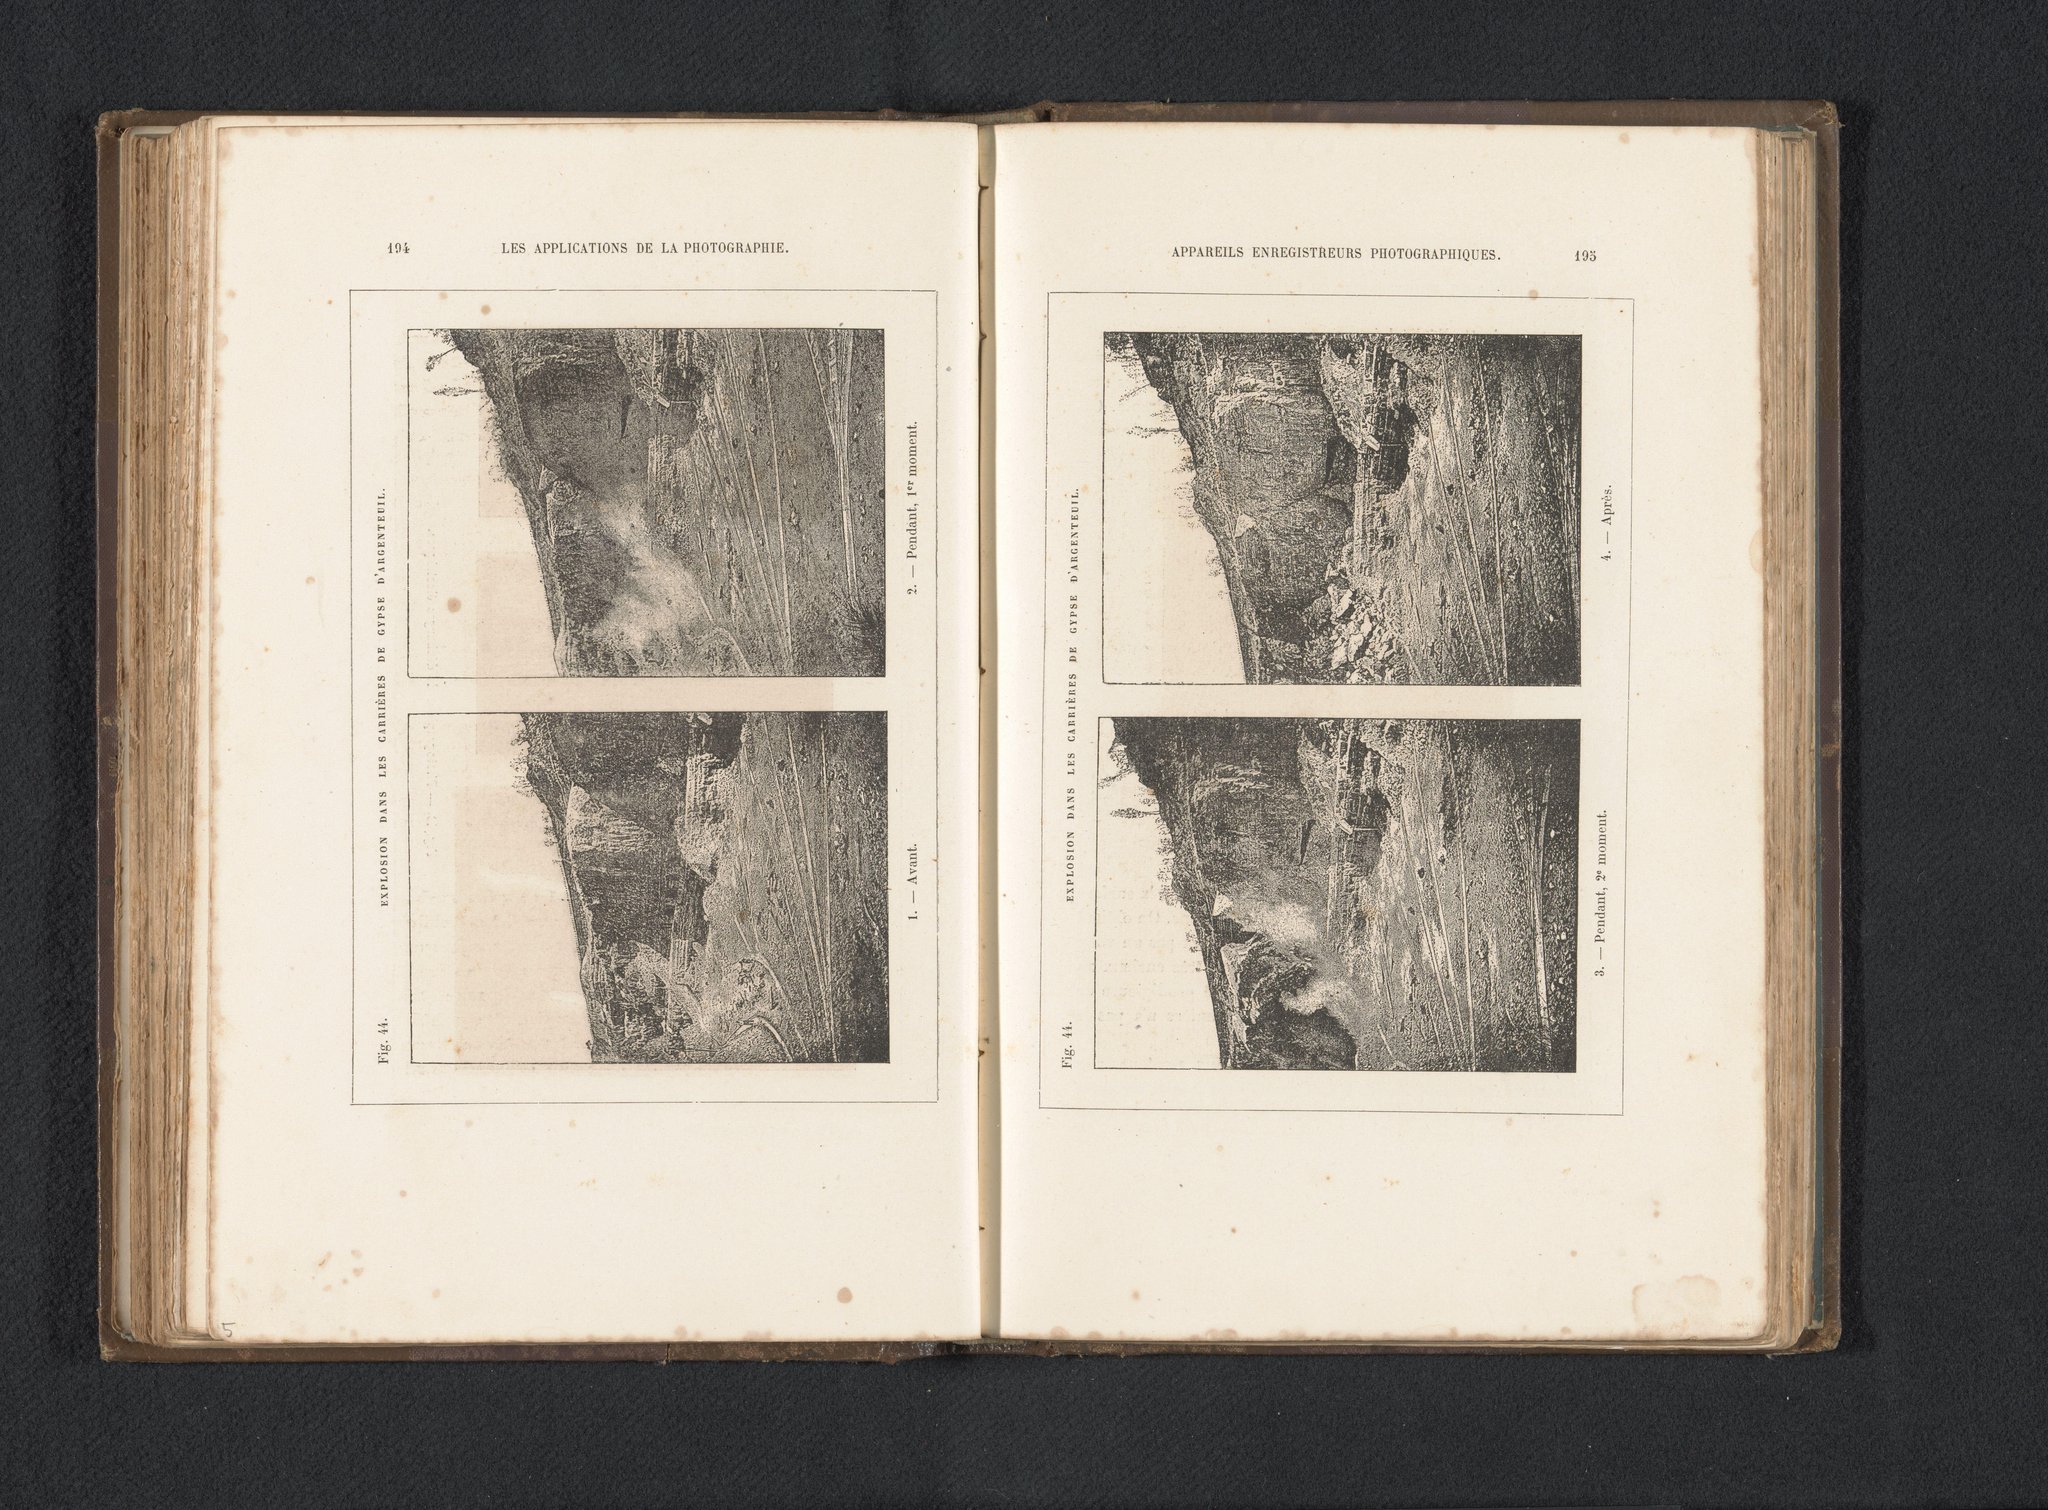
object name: photomechanical print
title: Twee opnamen van een steengroeve na een explosie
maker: Anonymous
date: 1883-1888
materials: paper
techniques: collo-autotype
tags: quarry (+ stone)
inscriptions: inscription: ‘Fig. 44. Expliosion dans les carrières de gypse d'argenteuil/ 3. - Pendant, 2e moment/ 4. - Après.’